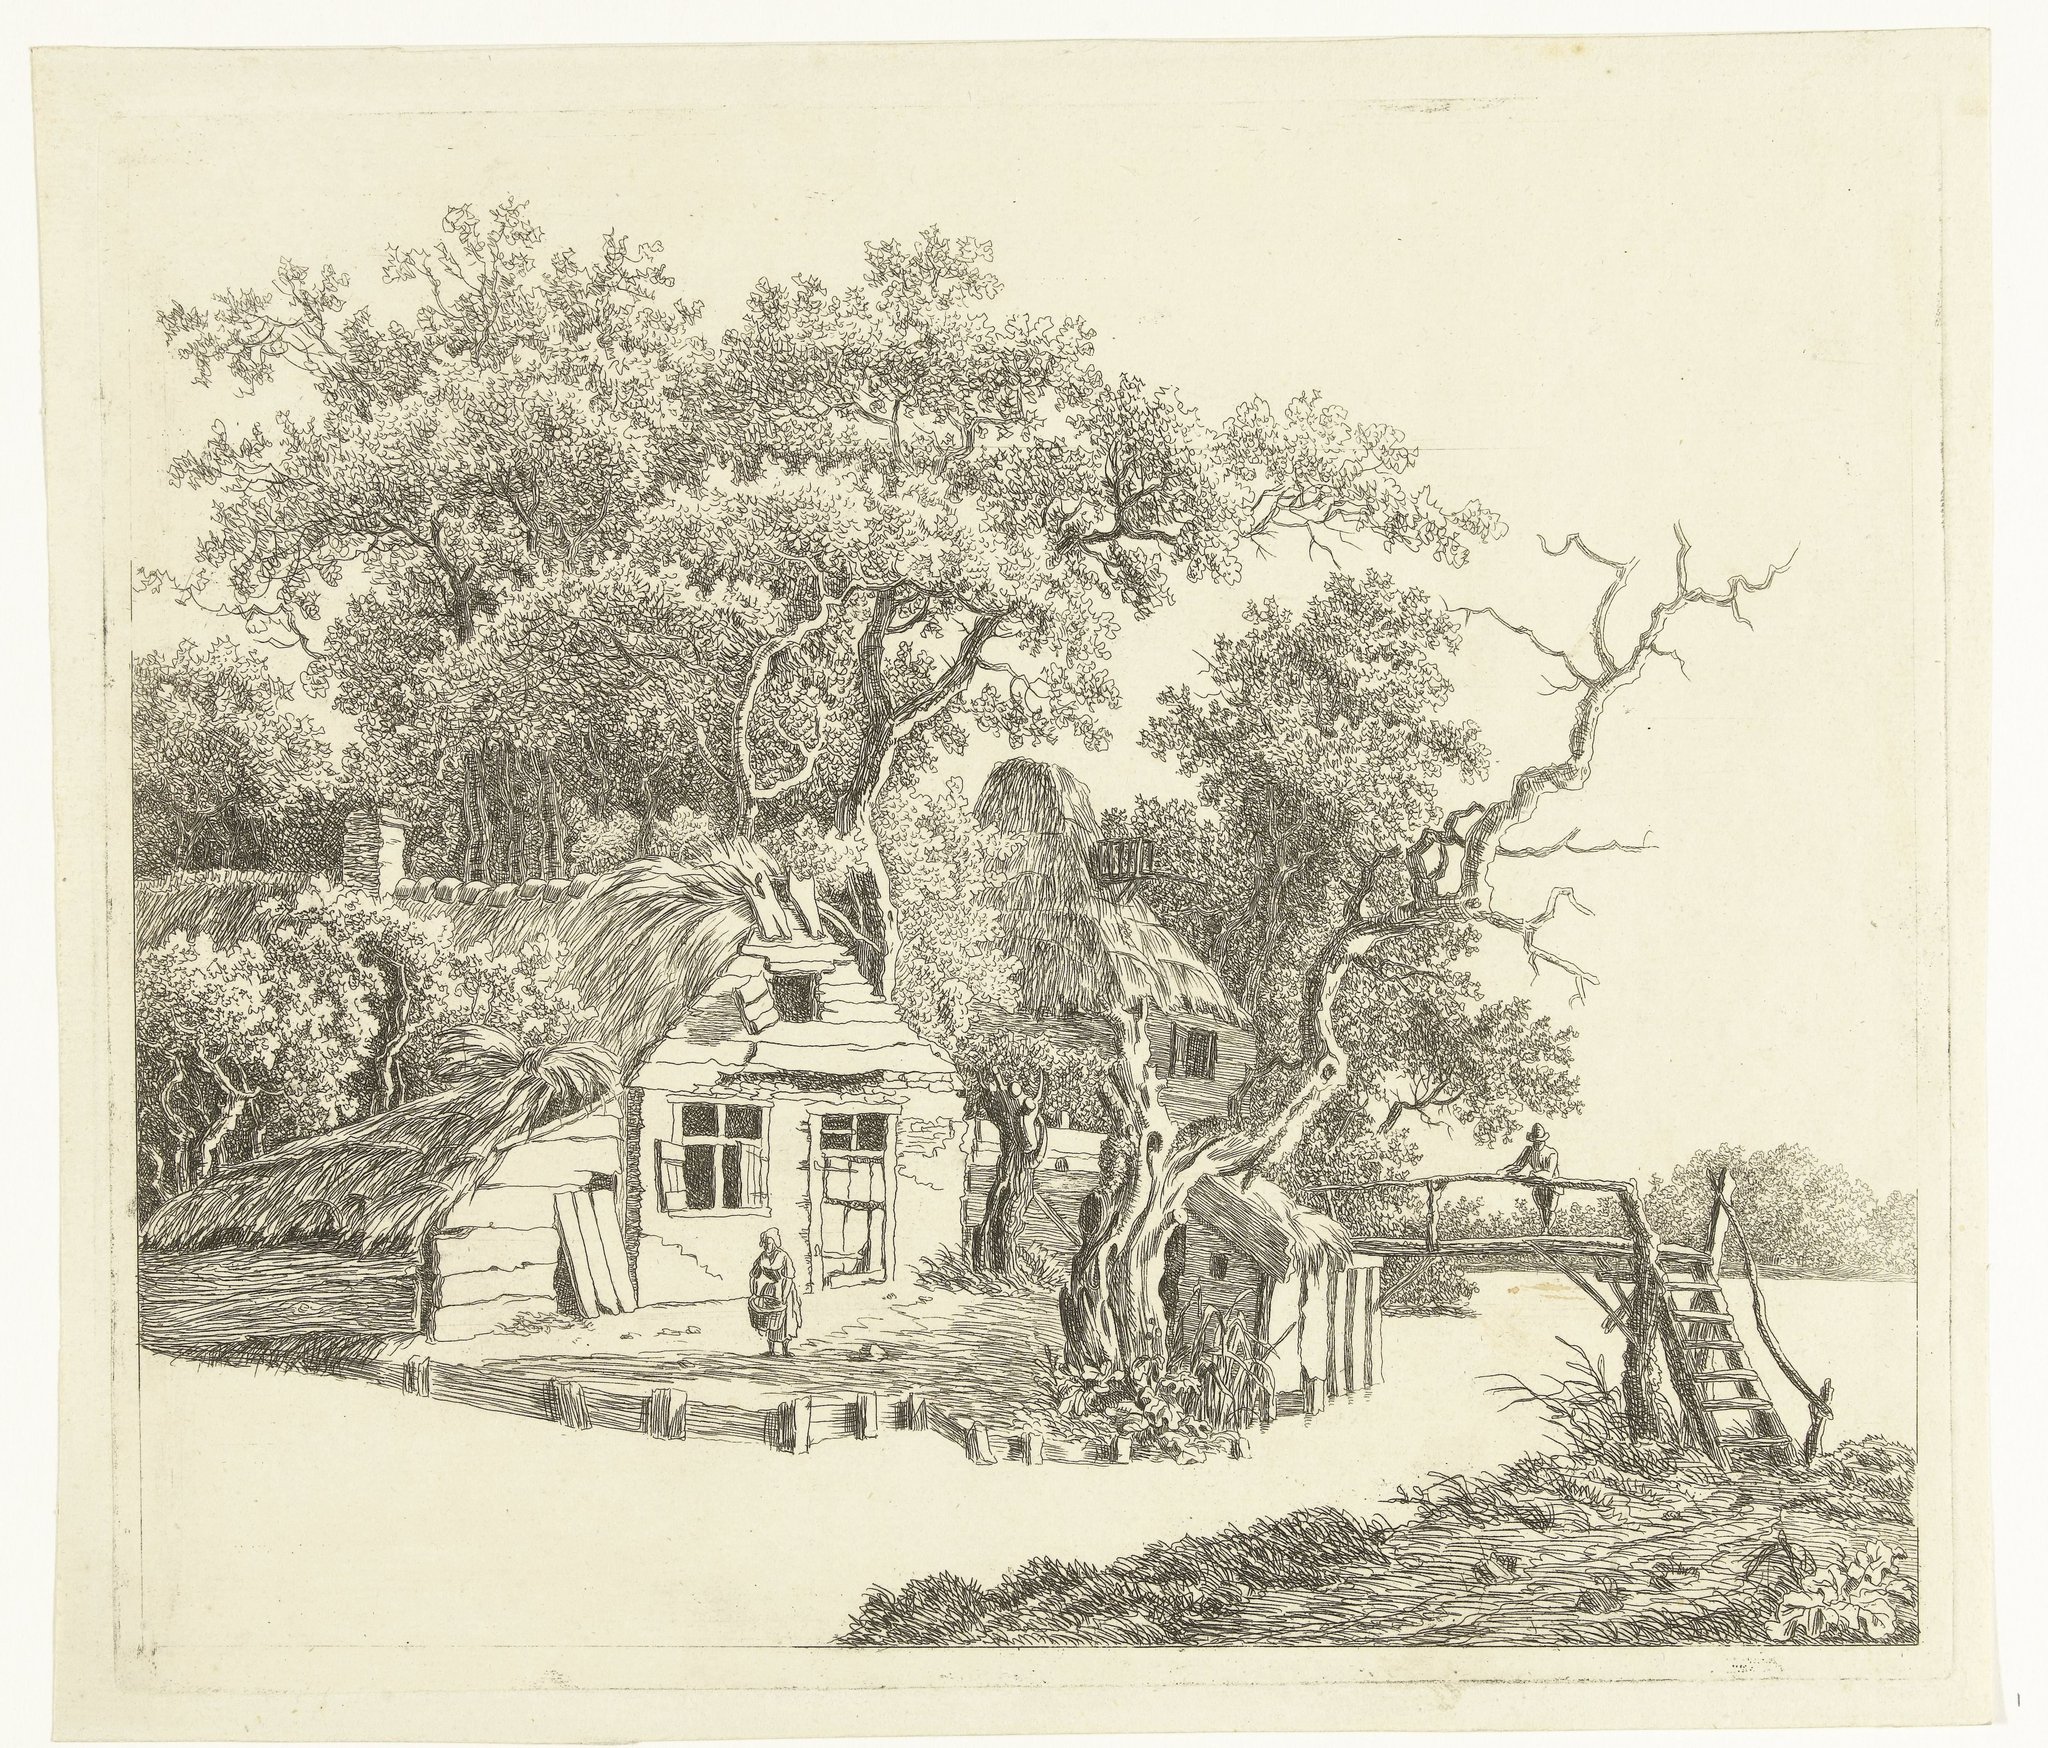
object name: print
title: Vervallen boerderij aan het water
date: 1778-1838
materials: paper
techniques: etching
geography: netherlands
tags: farm or solitary house in landscape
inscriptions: collector's mark: Lugt 2228